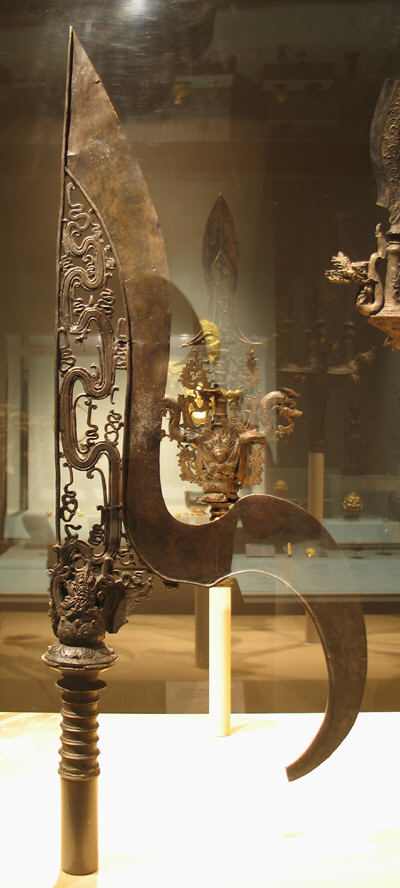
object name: halberd head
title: Halberd Head with Hooked Blade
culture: indonesian, javanese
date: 1251-1300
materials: copper alloy